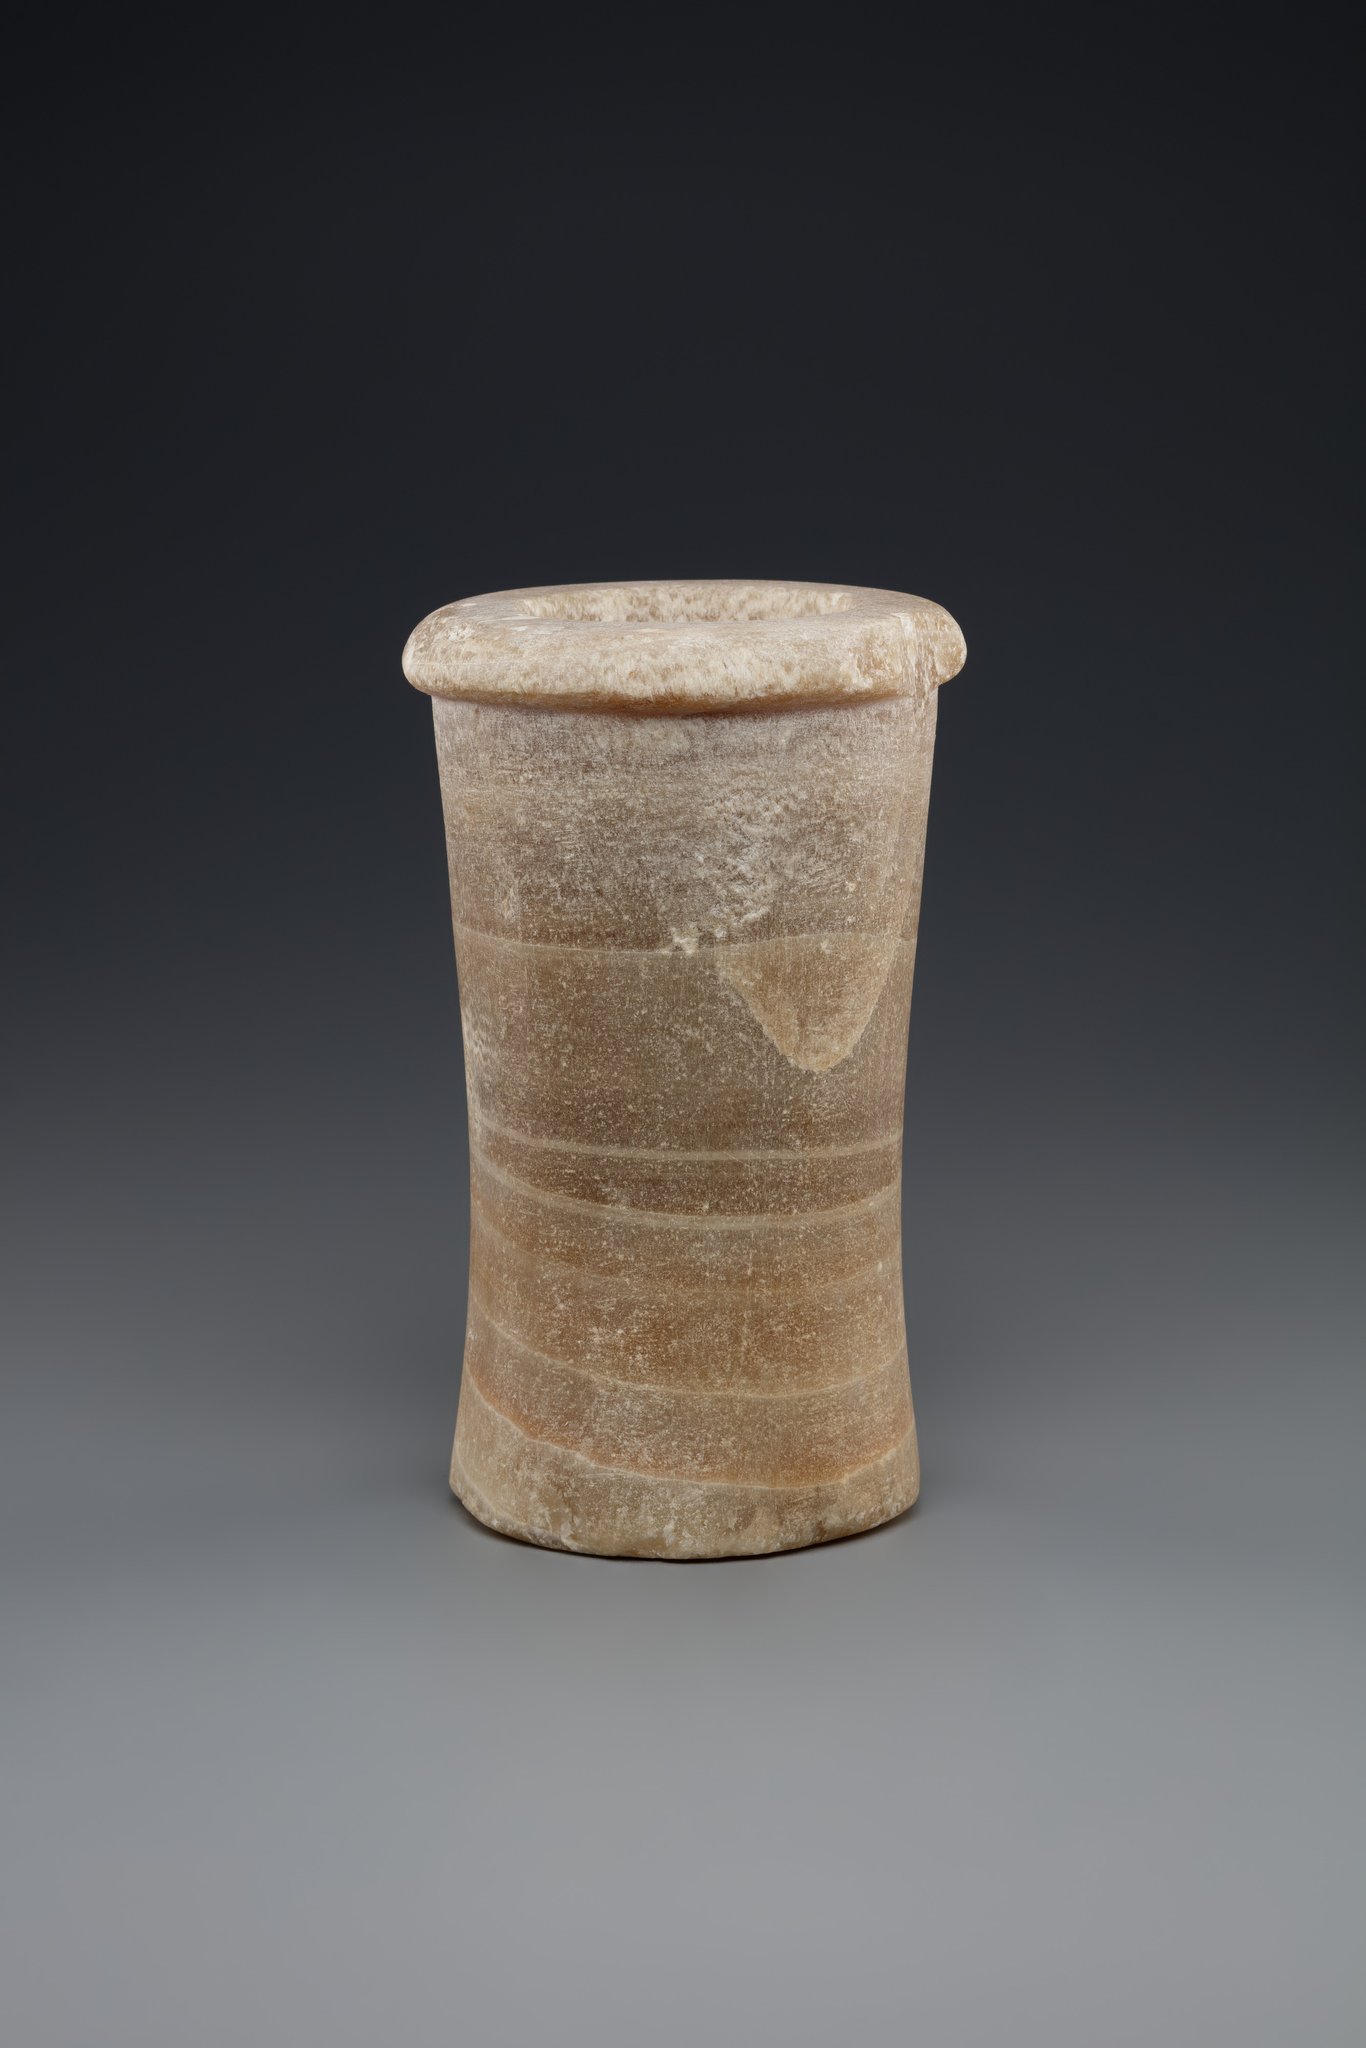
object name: jar, cylindrical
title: Cylinder jar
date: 3100-2649 BCE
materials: stone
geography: egypt